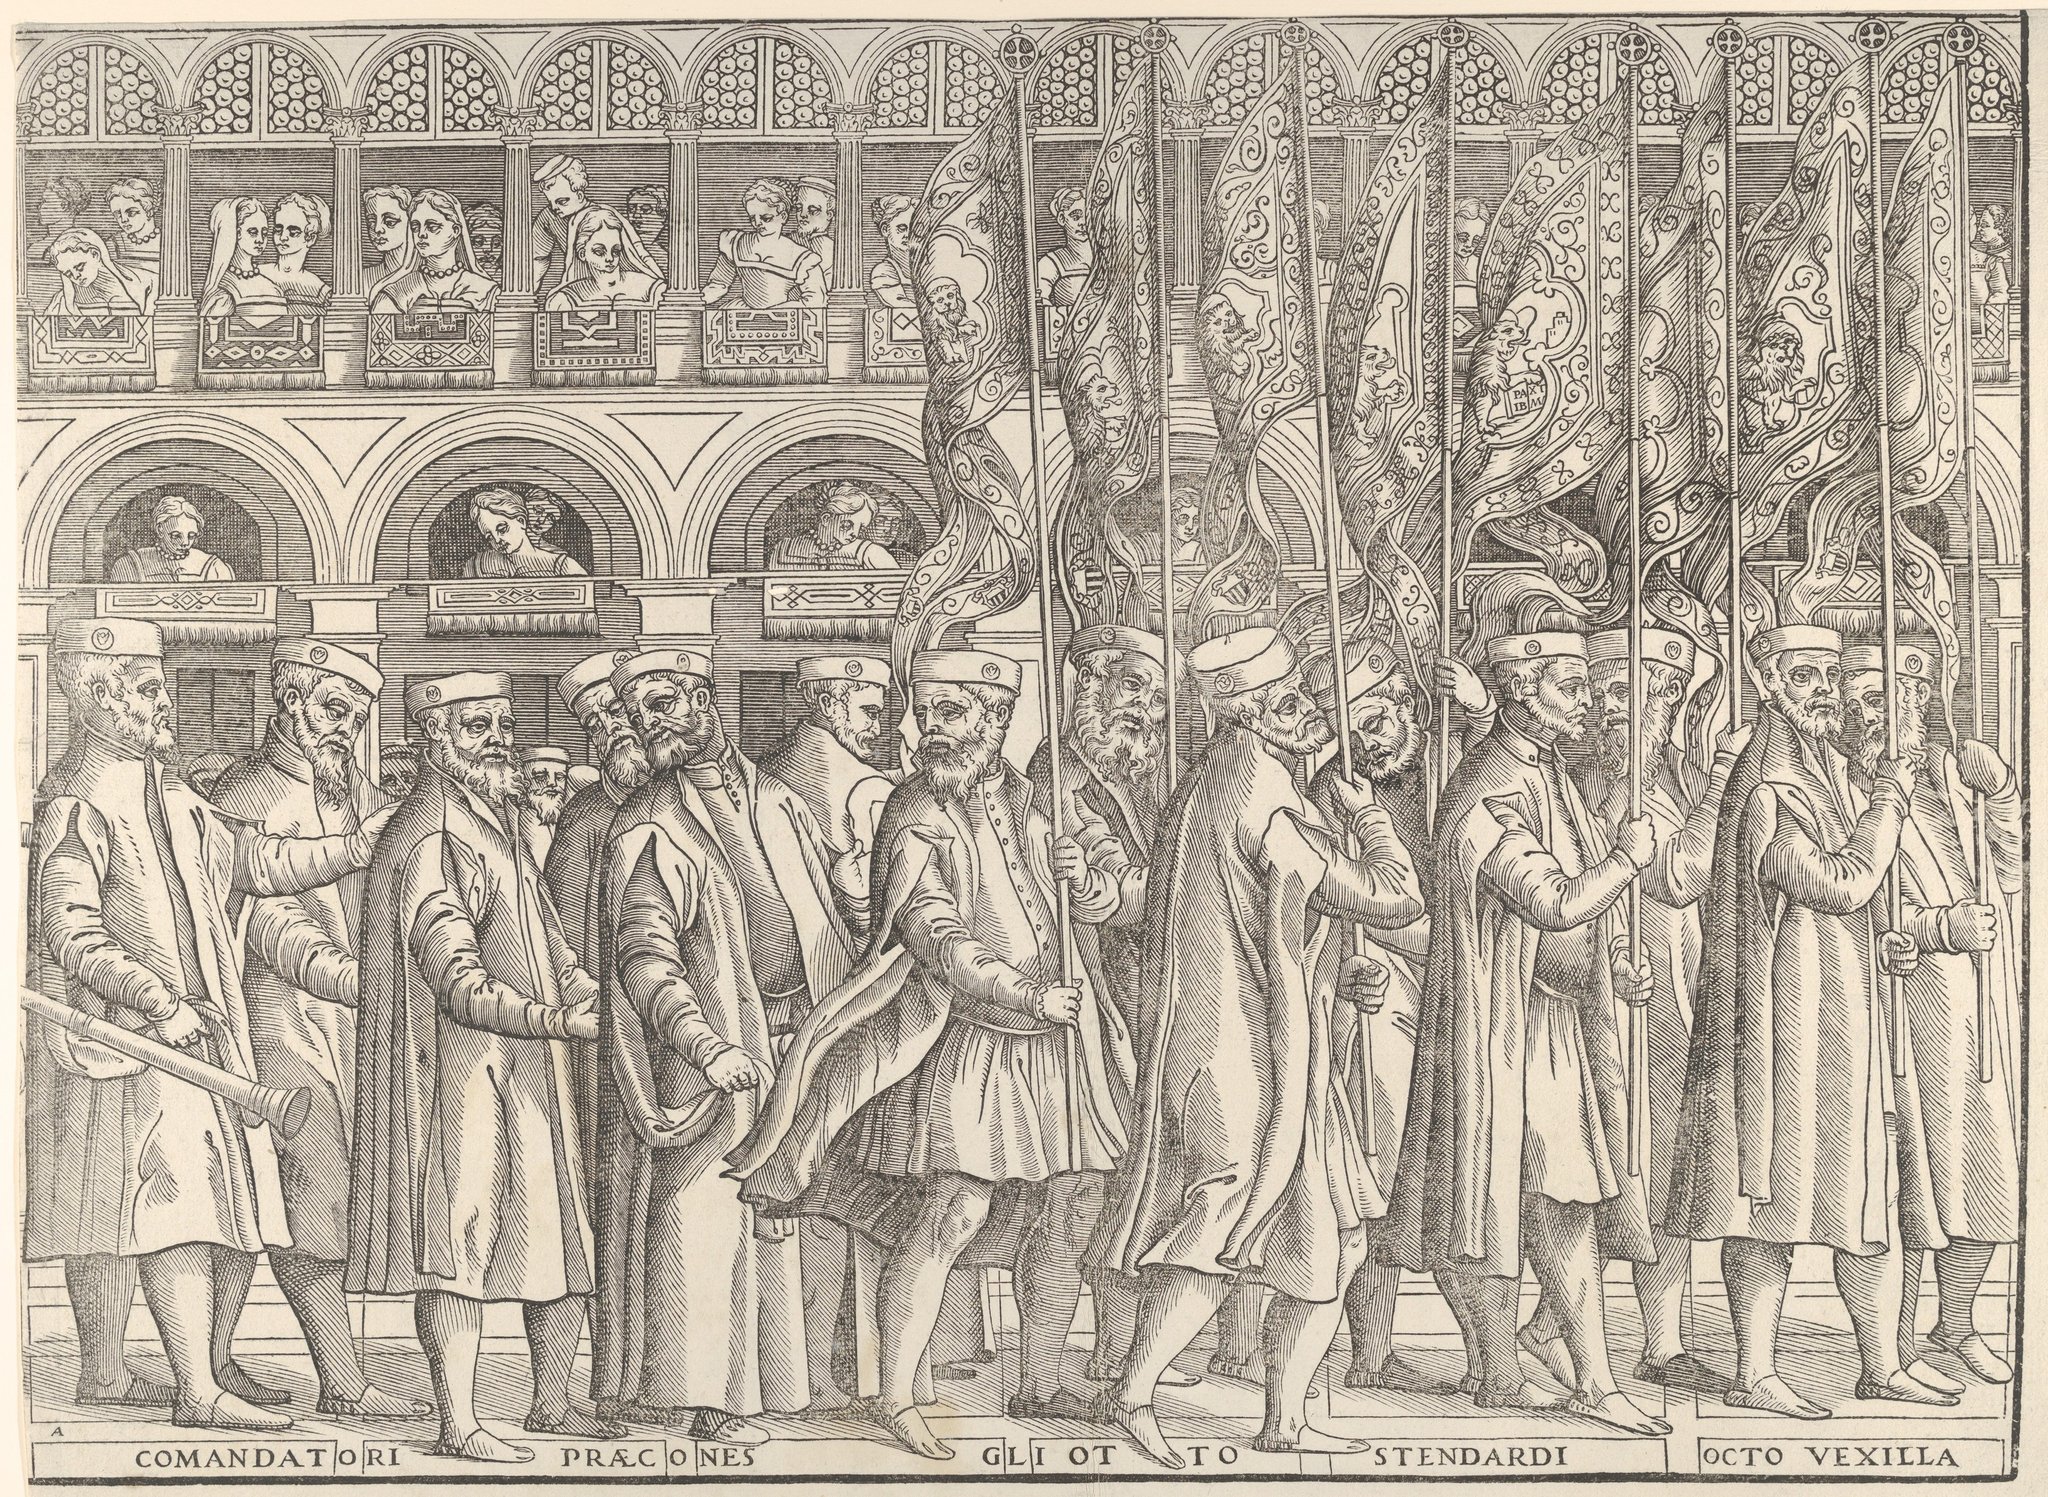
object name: print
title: Procession of the Doge in Venice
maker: matteo pagano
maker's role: publisher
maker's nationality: italian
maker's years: 1515-1588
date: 1556-1561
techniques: woodcut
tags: buildings,men,women,flags